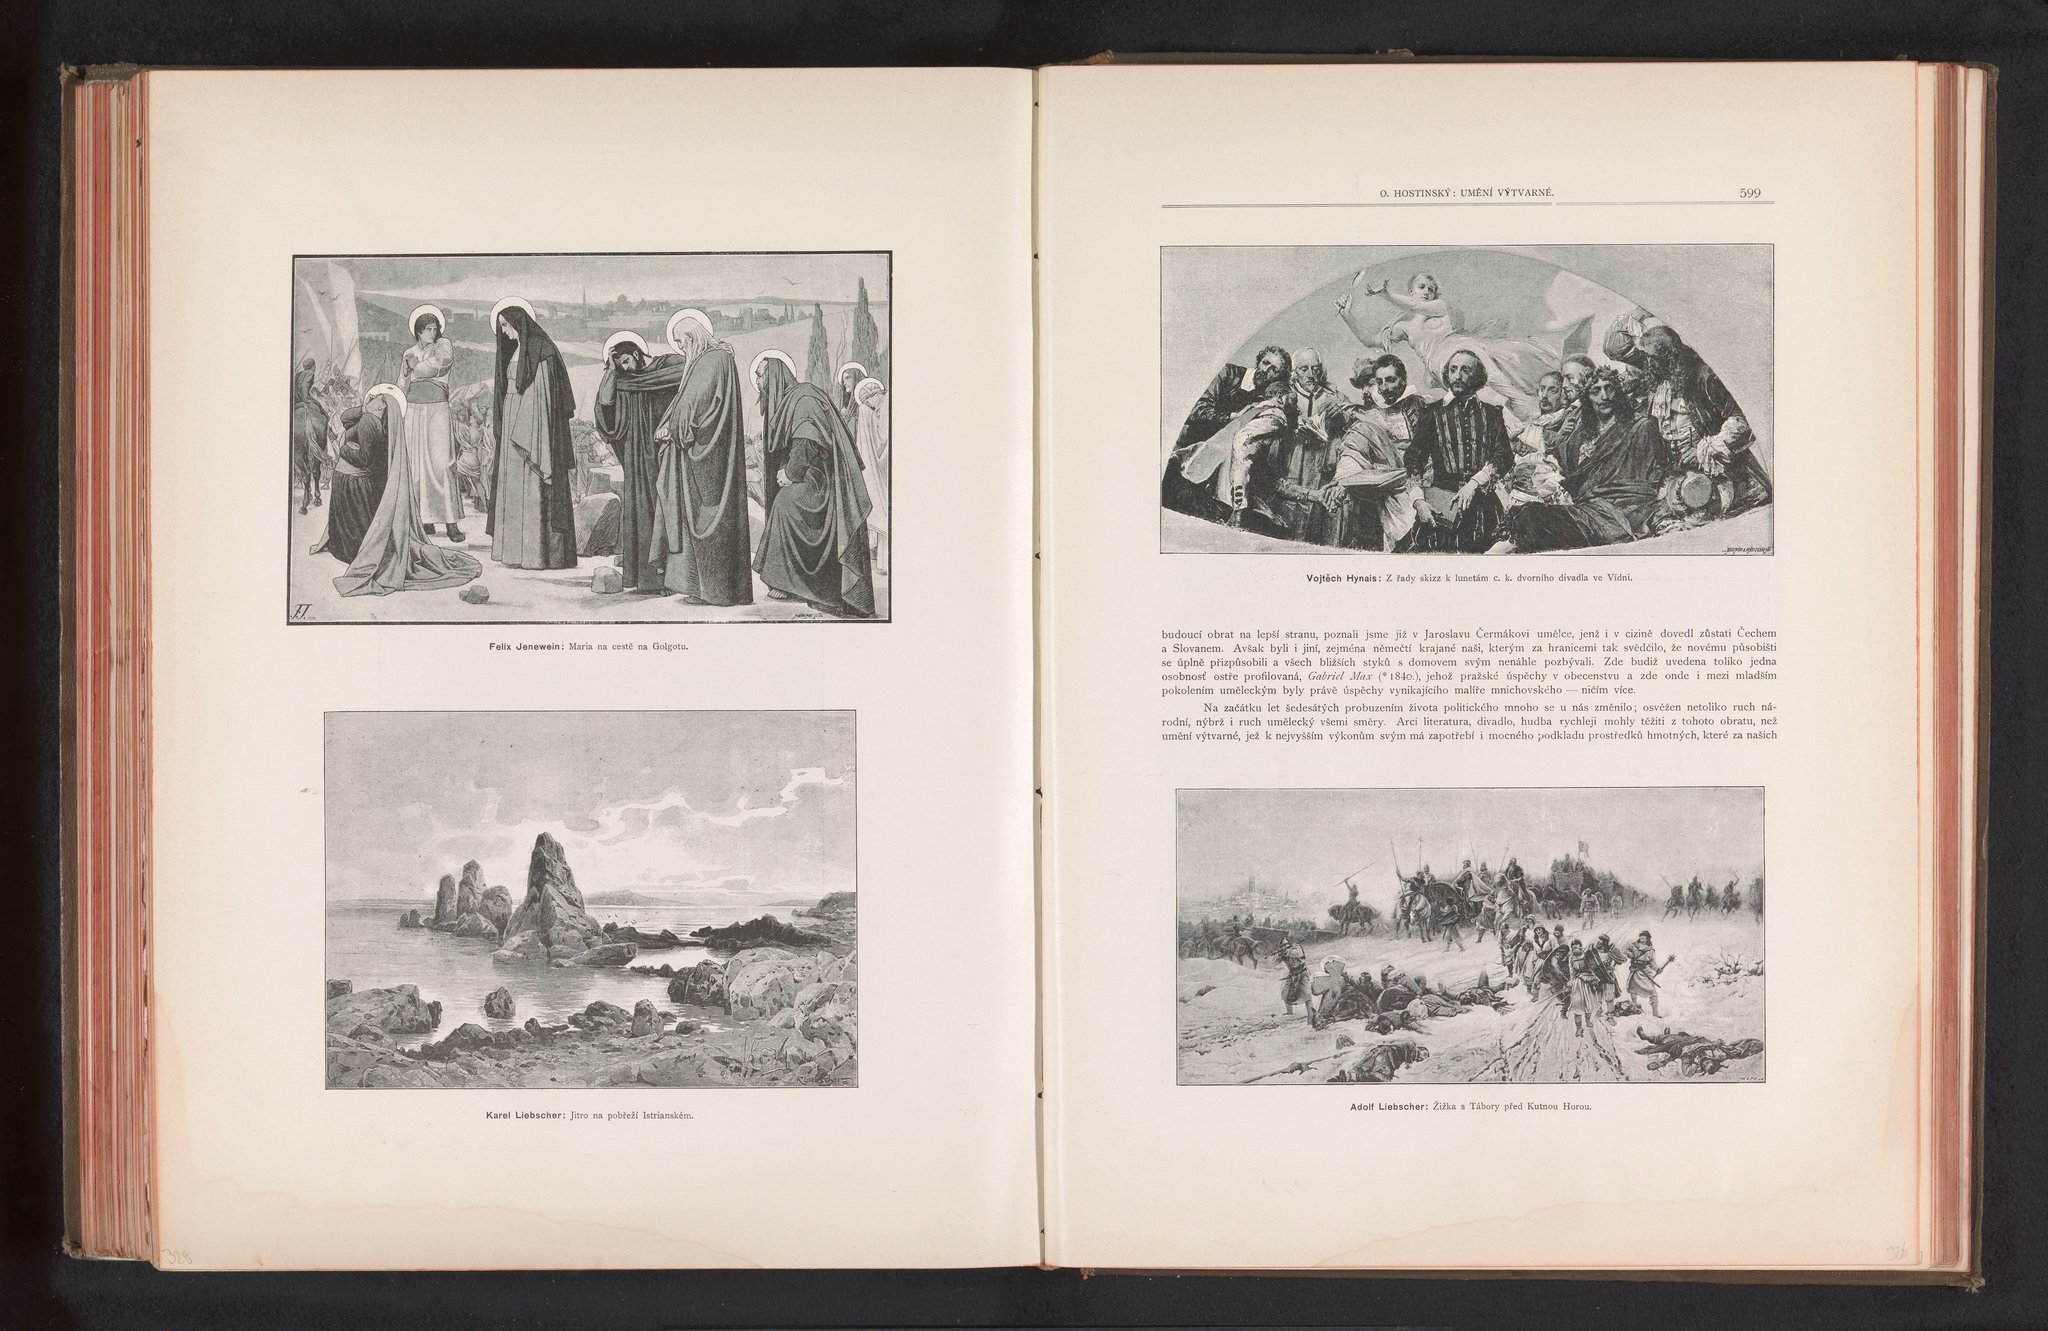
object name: reproduction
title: Felix Jenewein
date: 1891-1895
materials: paper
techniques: autotype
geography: prague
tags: rocky coast, bystanders at the foot of the cross, among whom mary, mary magdalene and john the evangelist; mary may be shown swooning